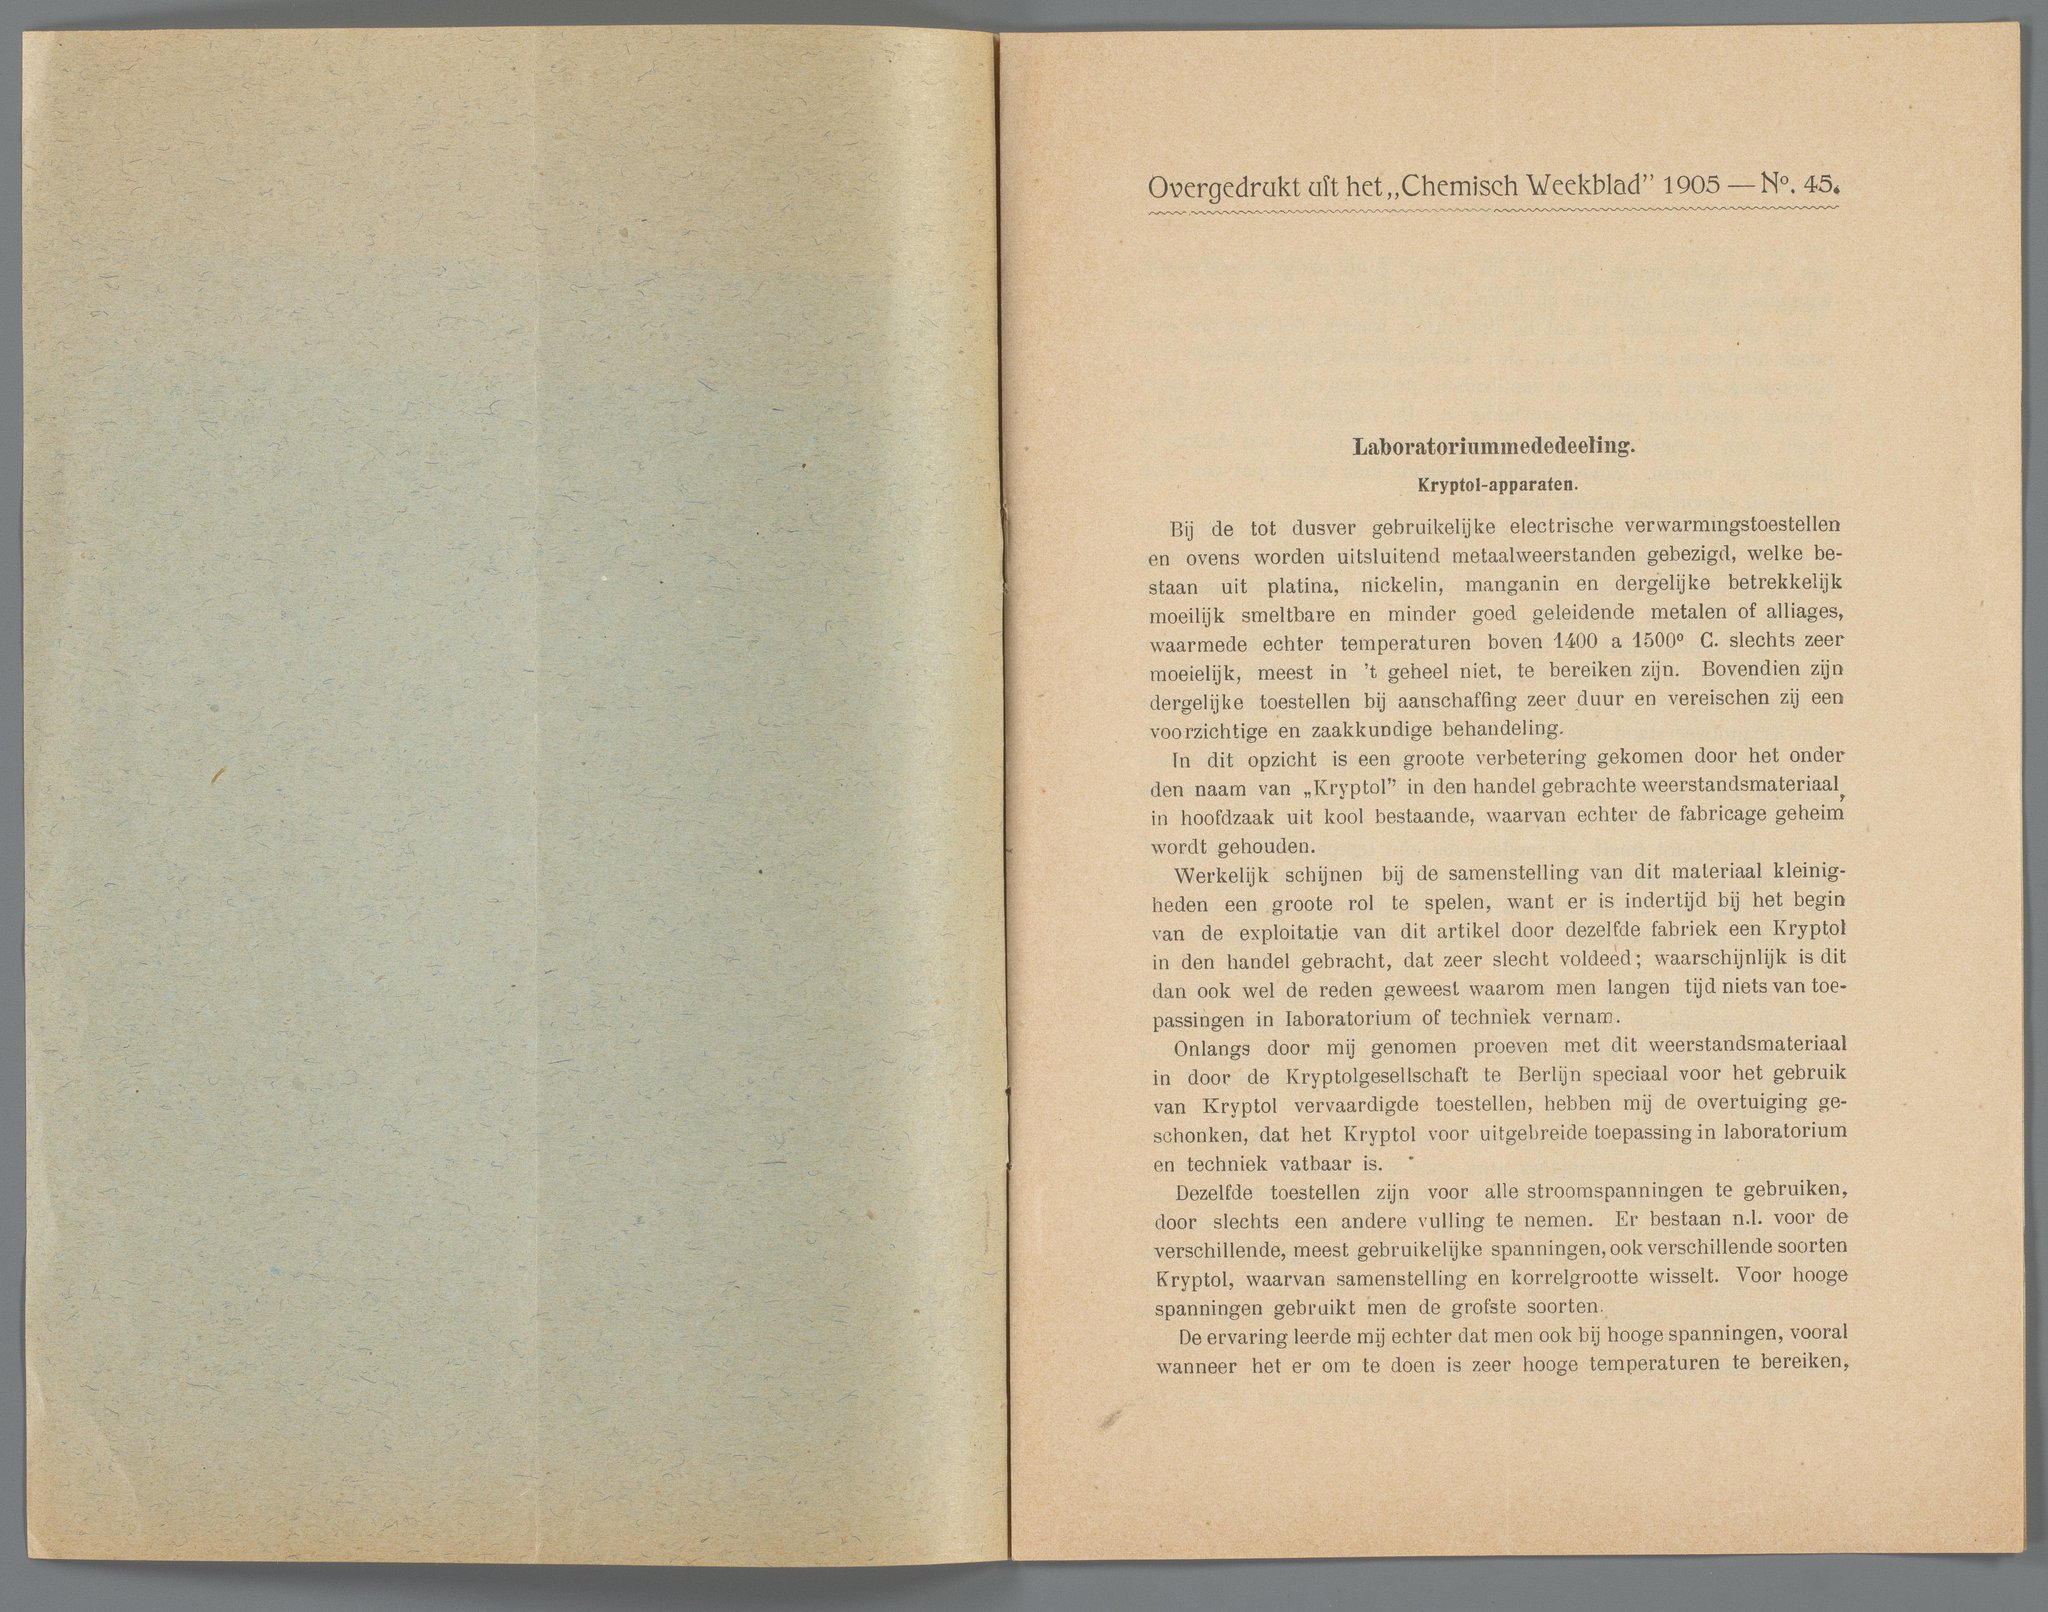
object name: offprint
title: Laboratoriummededeling over het materiaal Kryptol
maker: jacob olie jr.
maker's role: fotograaf, scheikundige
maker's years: 1879-1955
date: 1905-1910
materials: paper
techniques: letterpress printing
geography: amsterdam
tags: printed matter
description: Overdruk uit het Chemisch Weekblad, nummer 45, 1905.